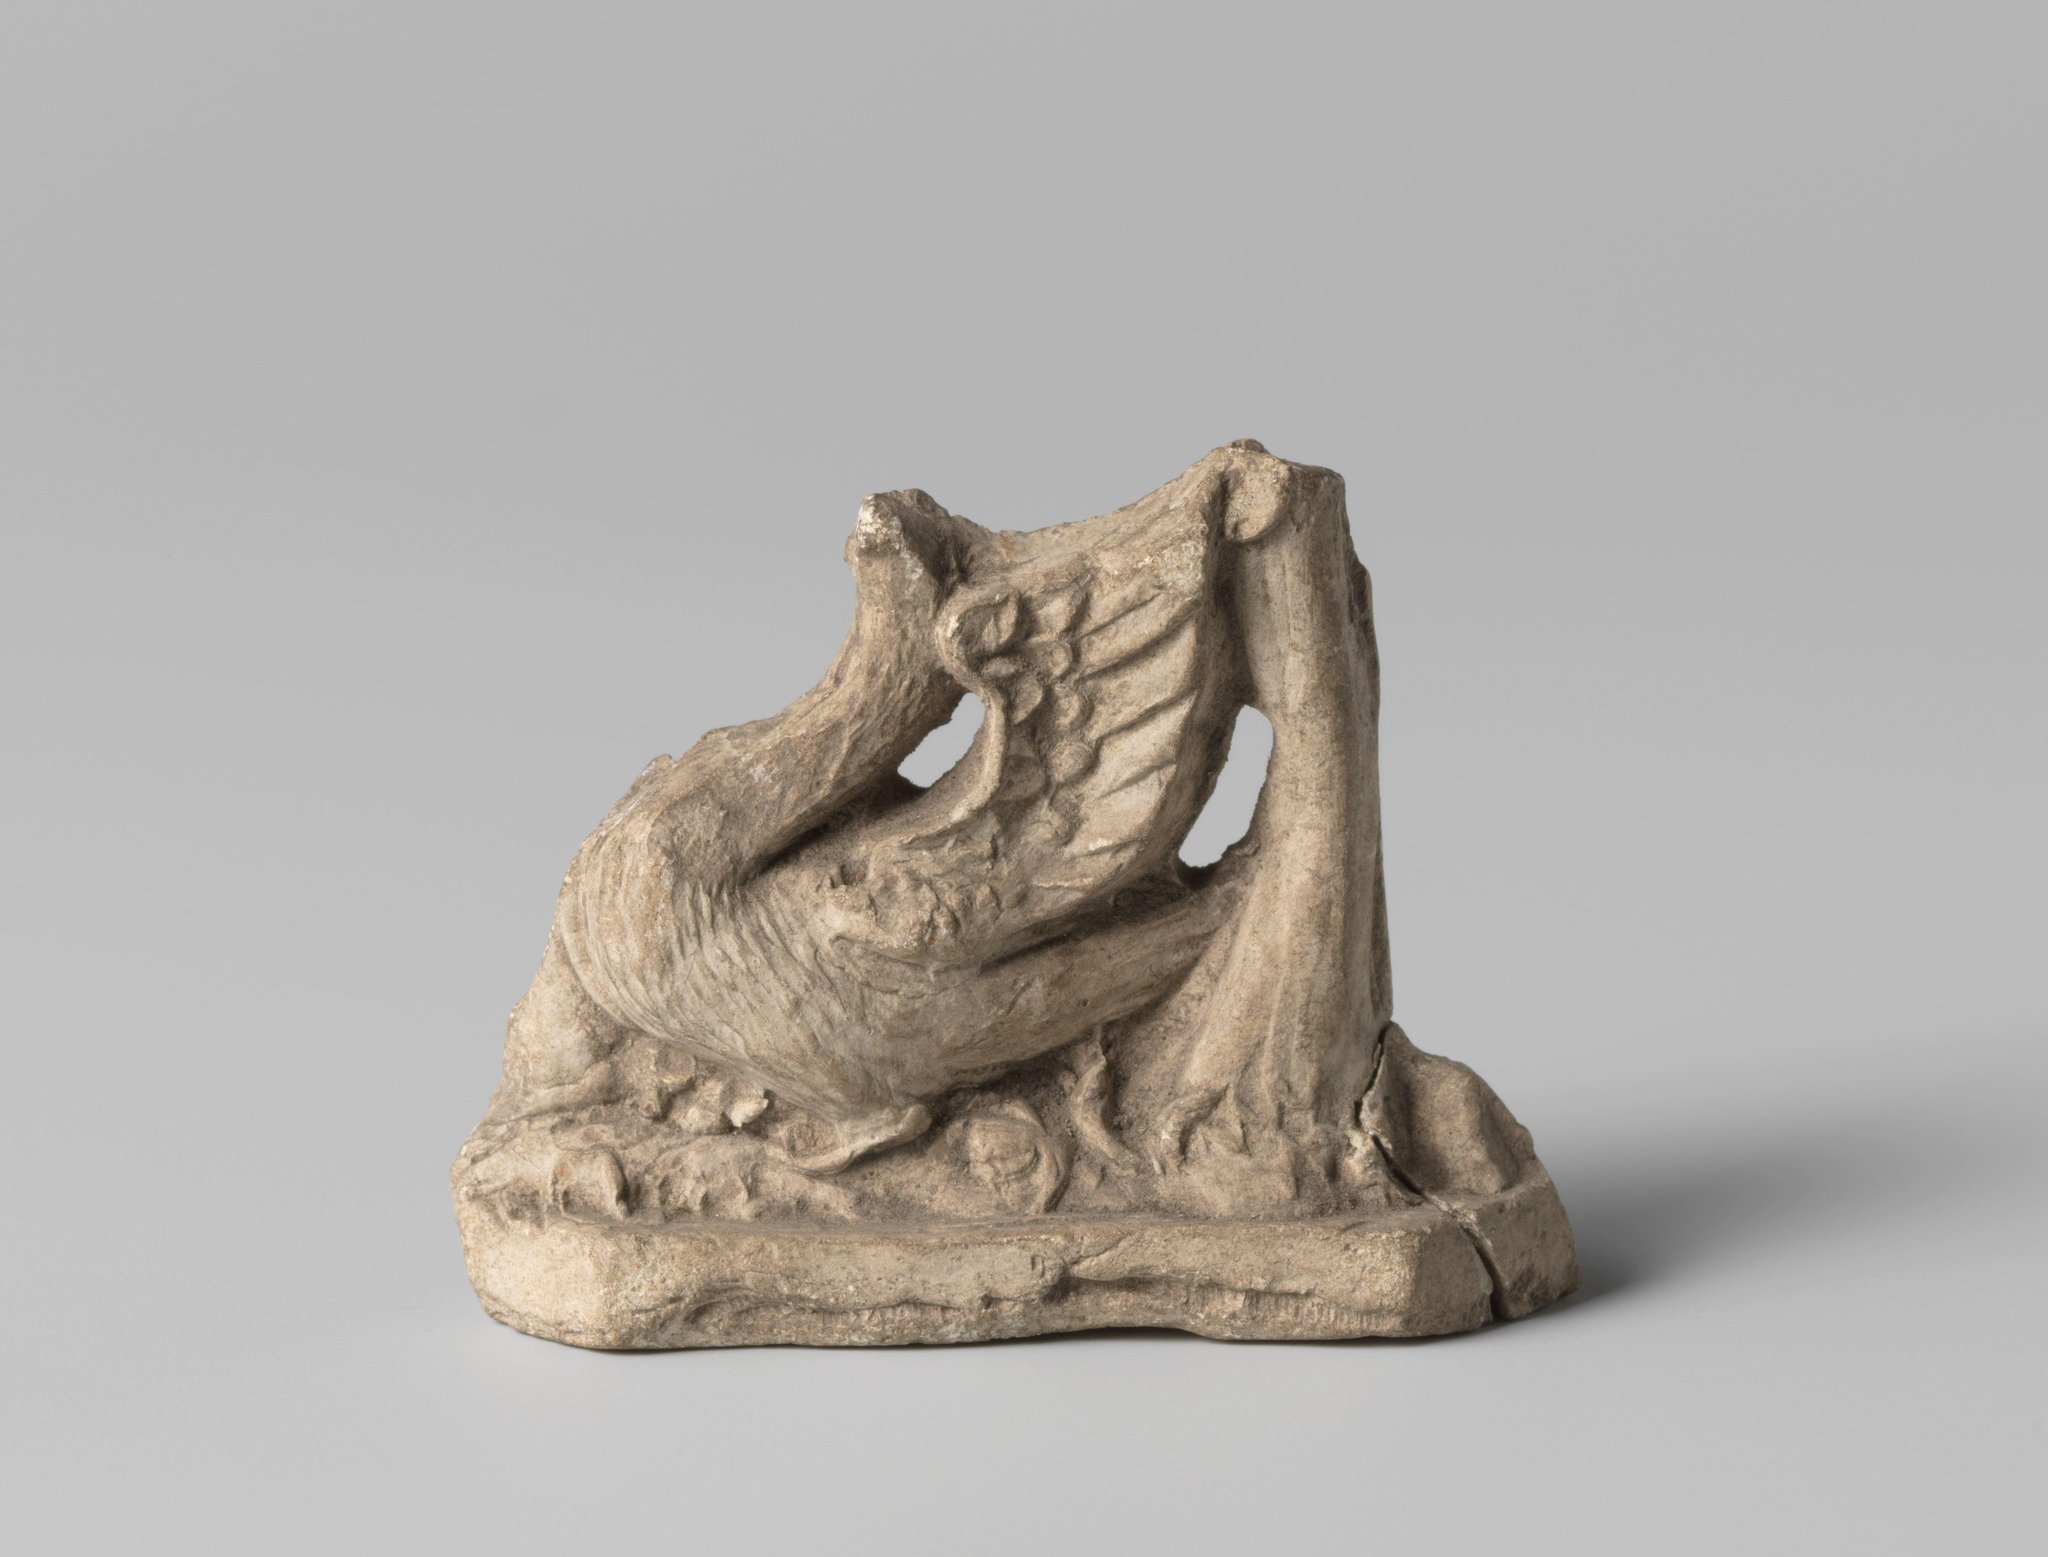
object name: sculpture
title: Fragment van een beeldhouwwerk.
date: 1400-1950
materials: stone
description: Fragment van een beeldhouwwerk in de vorm van een zwaan.